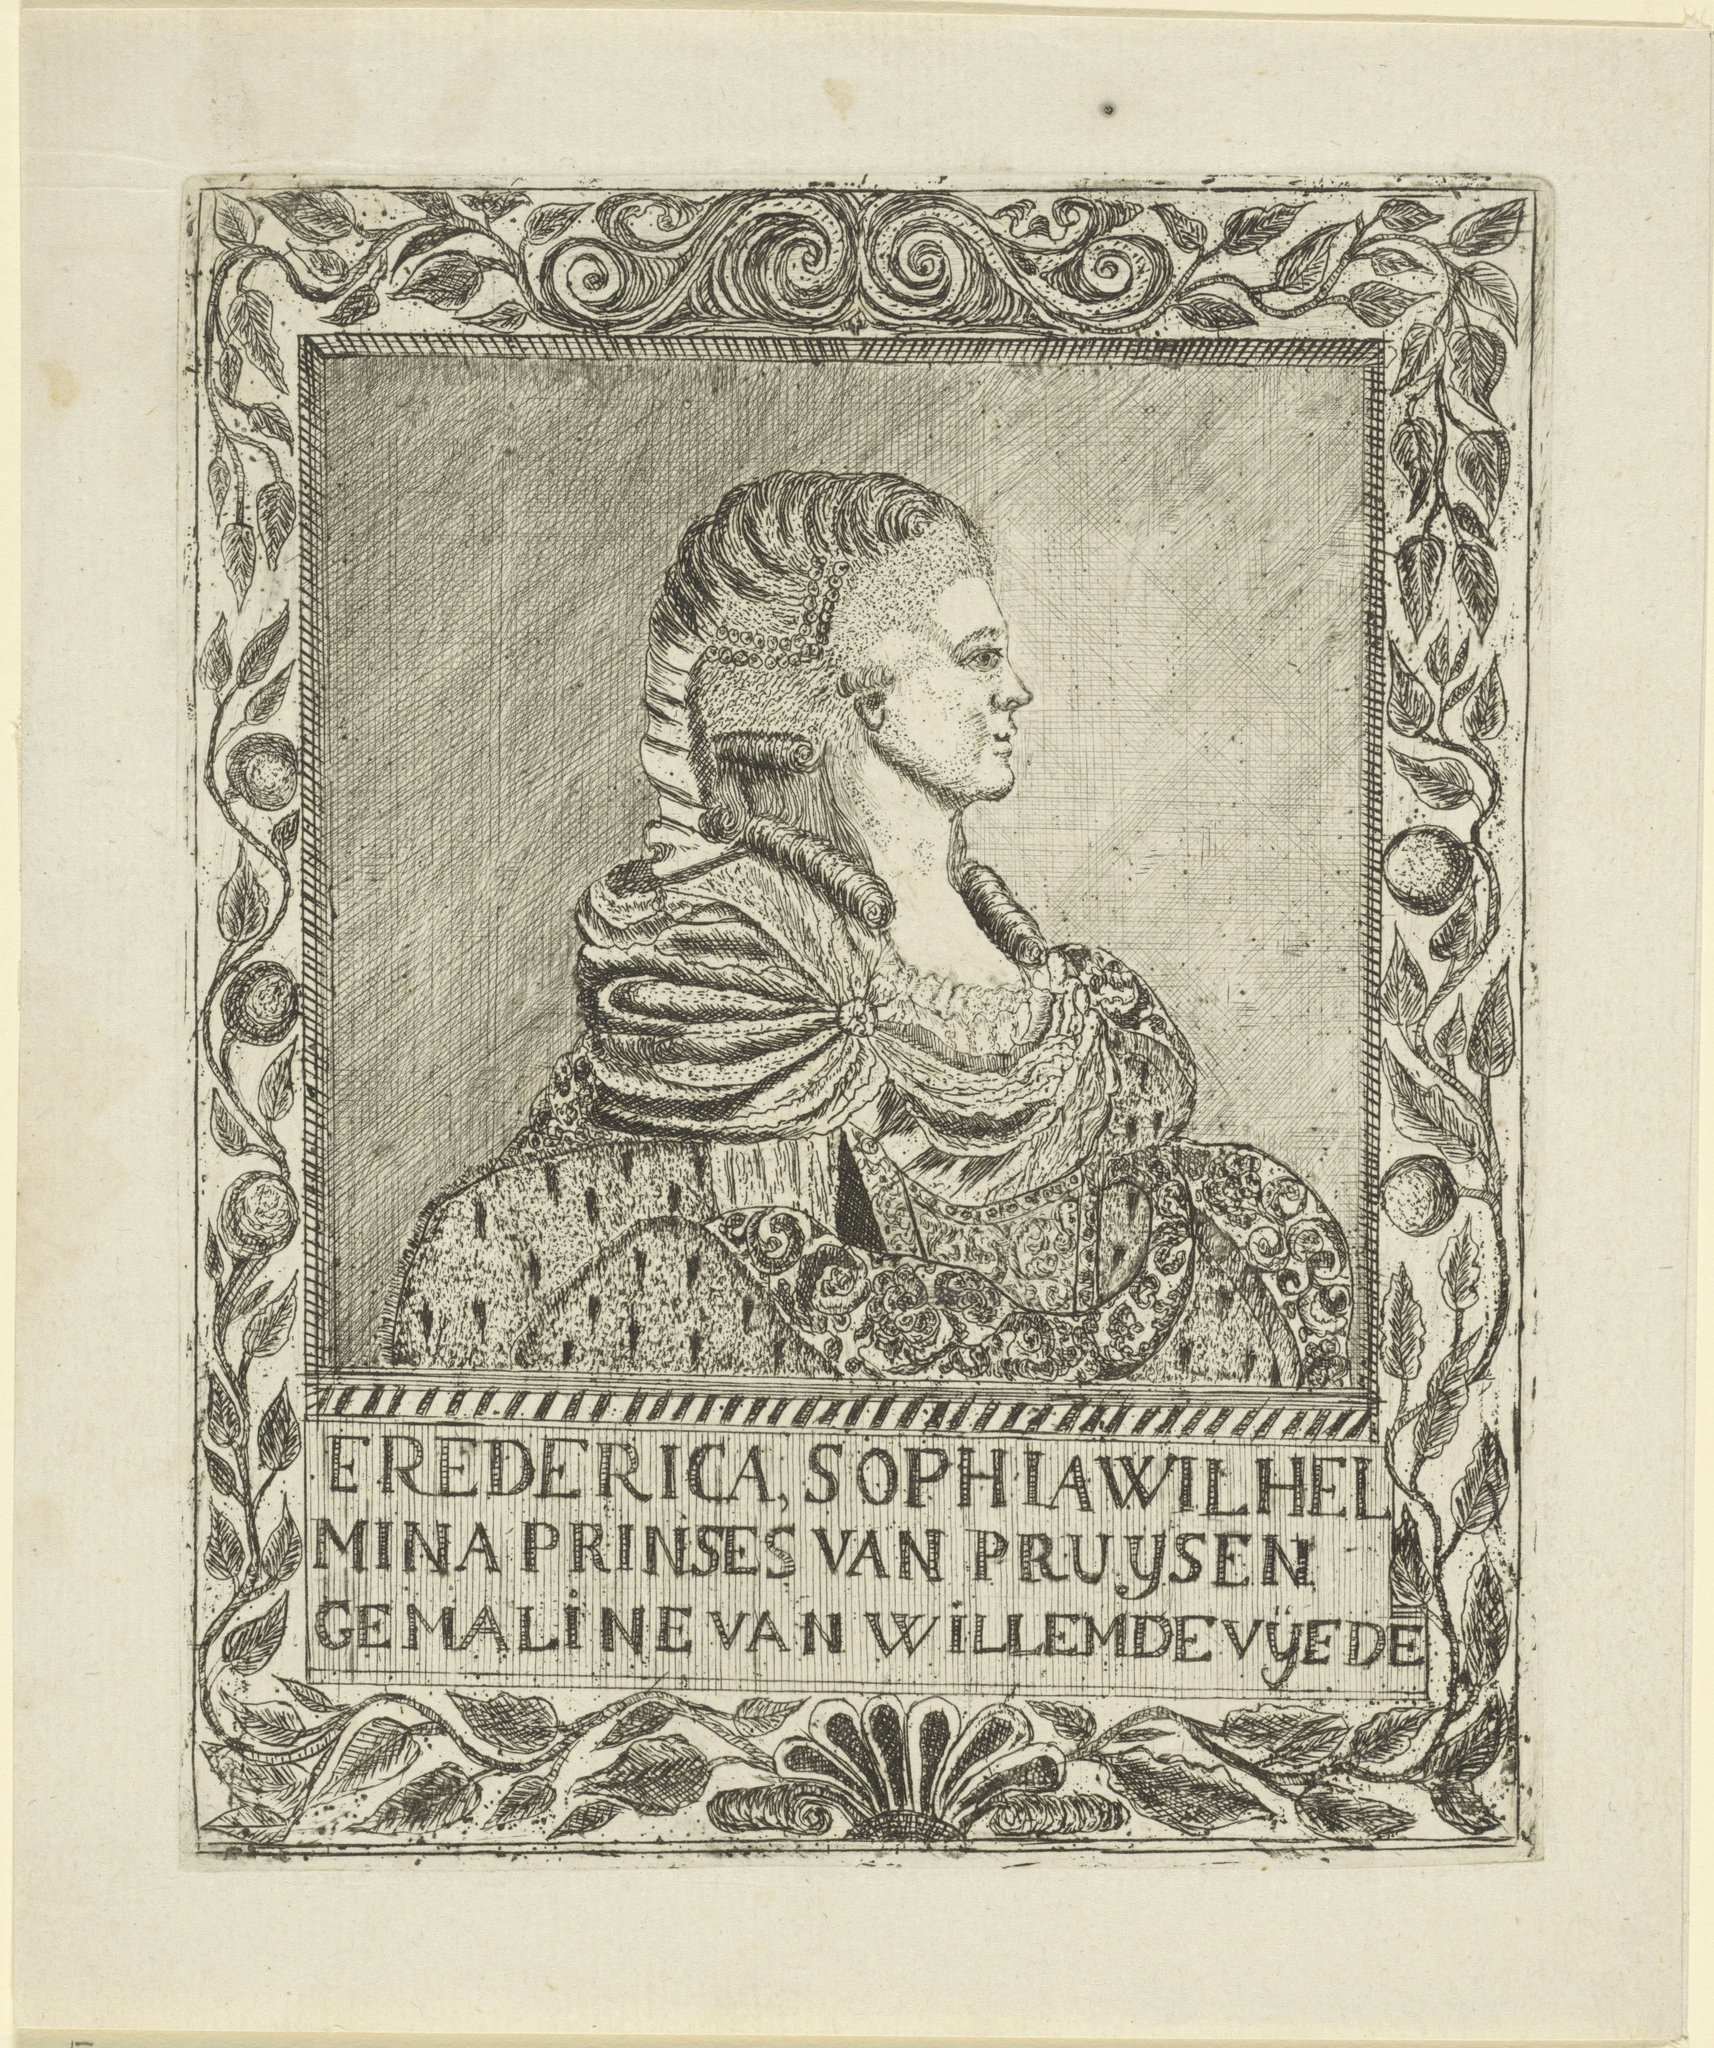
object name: print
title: Portret van Wilhelmina van Pruisen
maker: Anonymous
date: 1767-1849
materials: paper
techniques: etching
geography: low countries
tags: wilhelmina of prussia (princess of orange)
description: Portret van Wilhelmina. In een kader drie regels Nederlandse tekst. Geheel in een geornamenteerde omlijsting met oranjetakken.